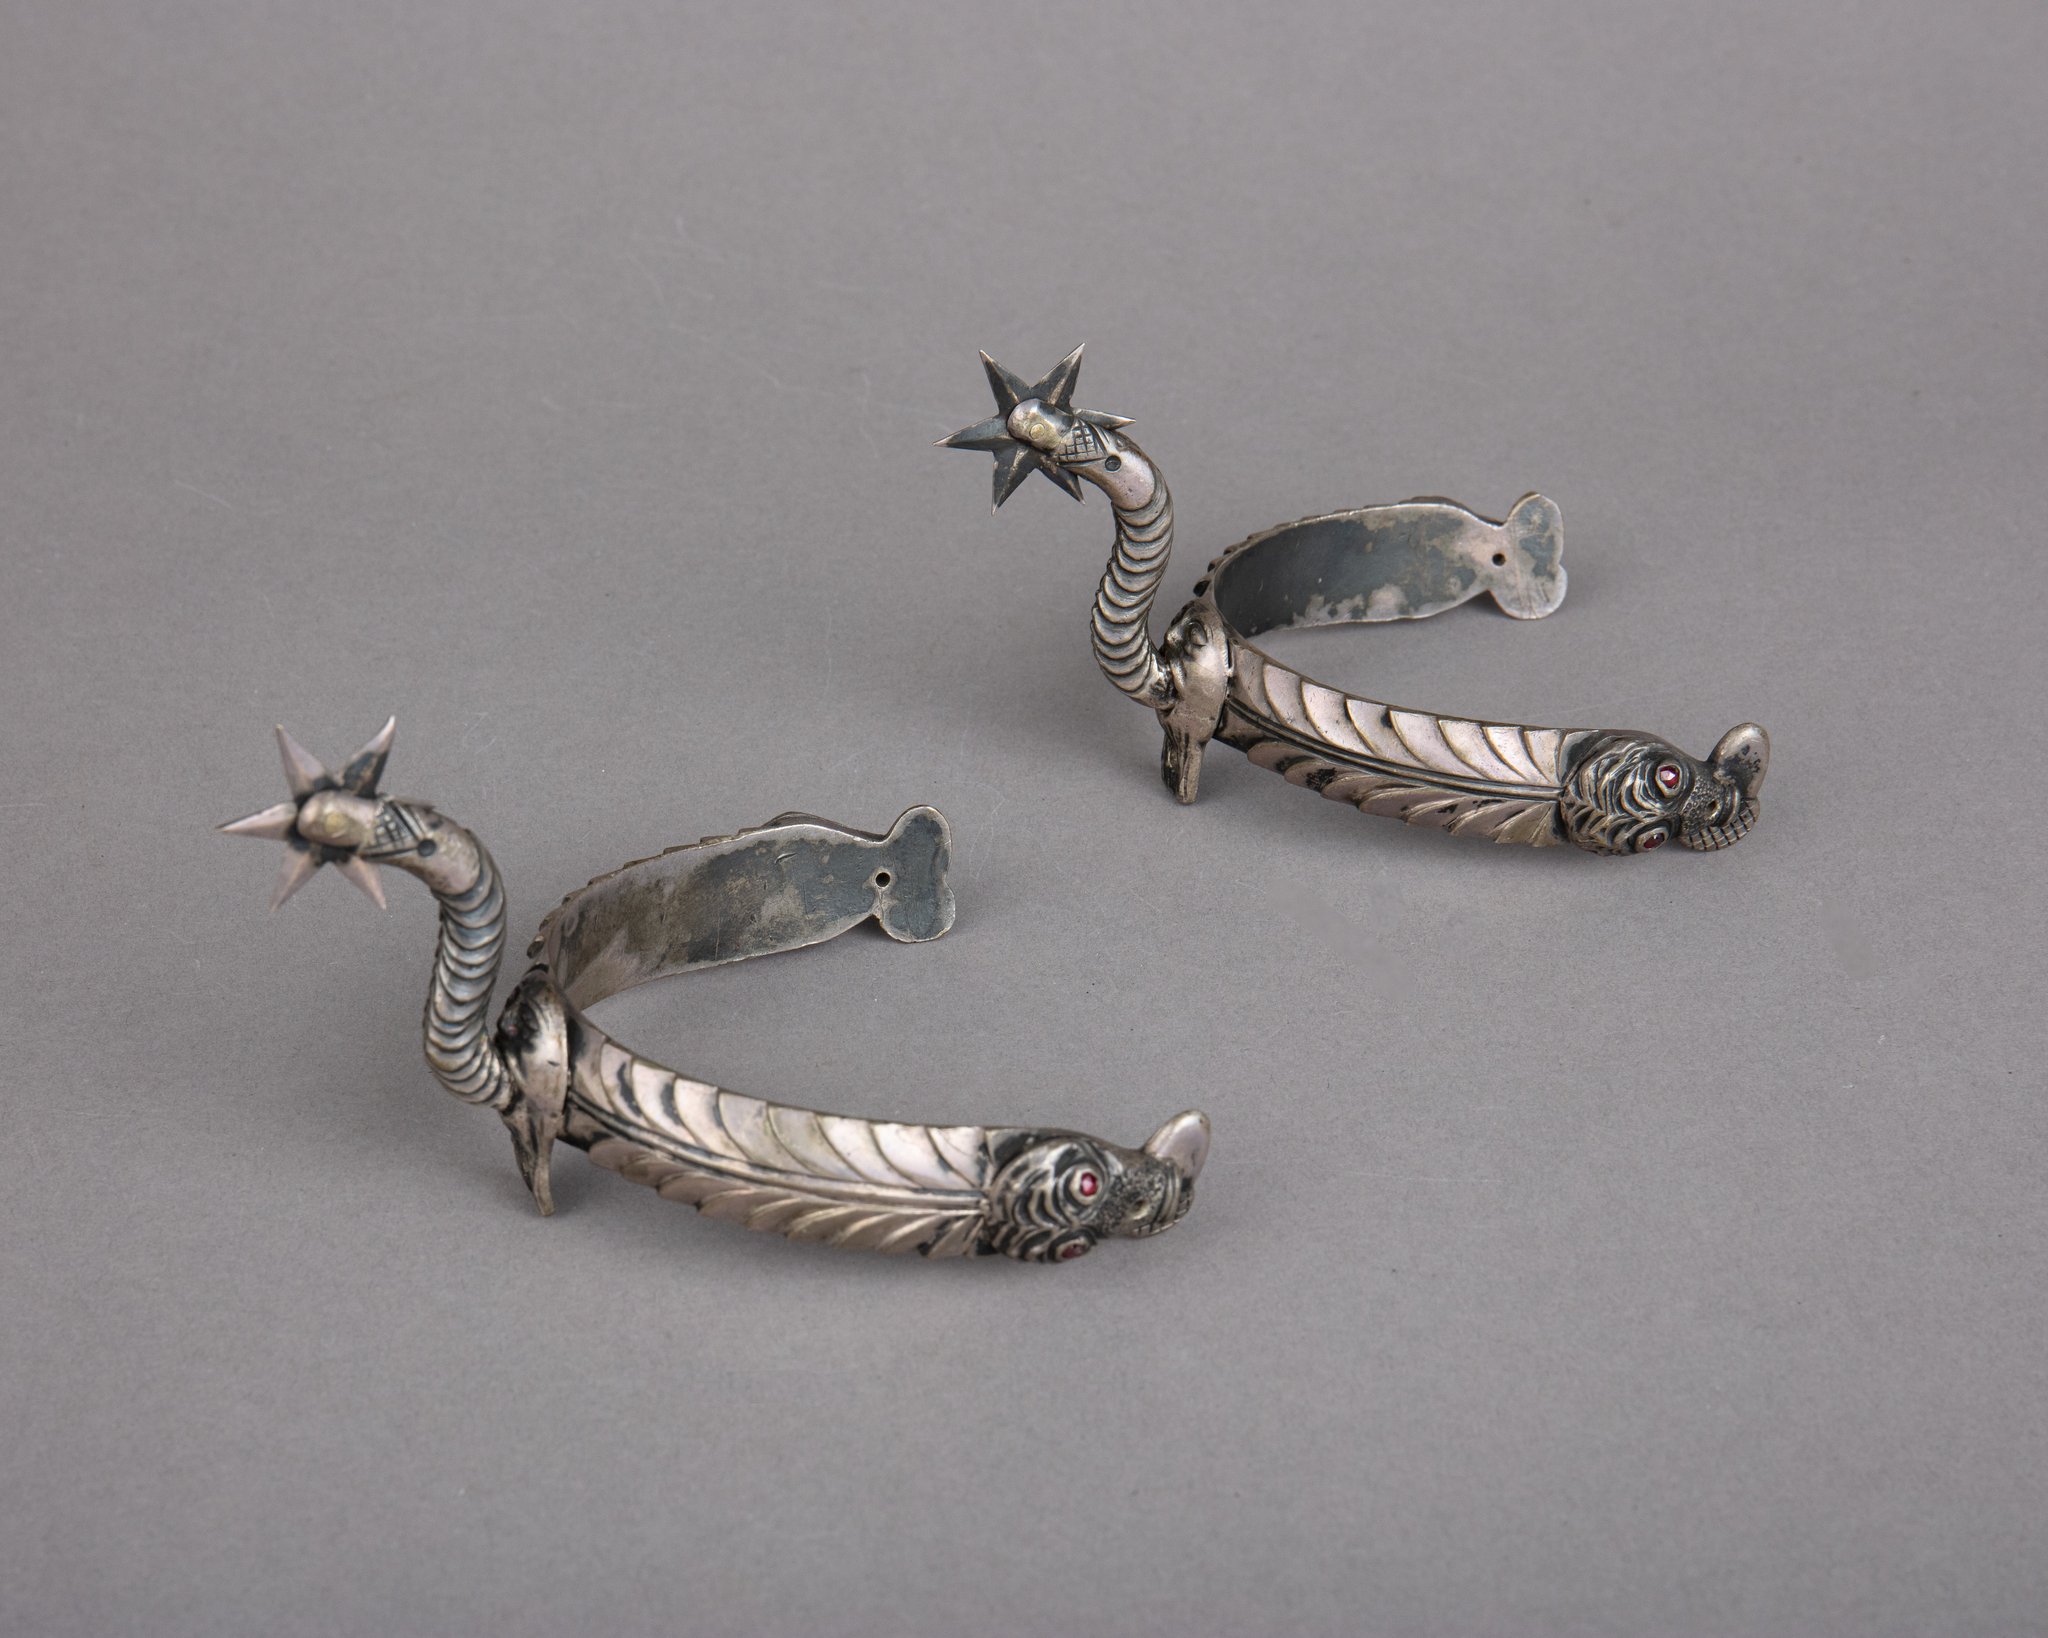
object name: spur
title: Pair of Rowel Spurs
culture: danish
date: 1801-1900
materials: copper alloy, glass, silver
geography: denmark